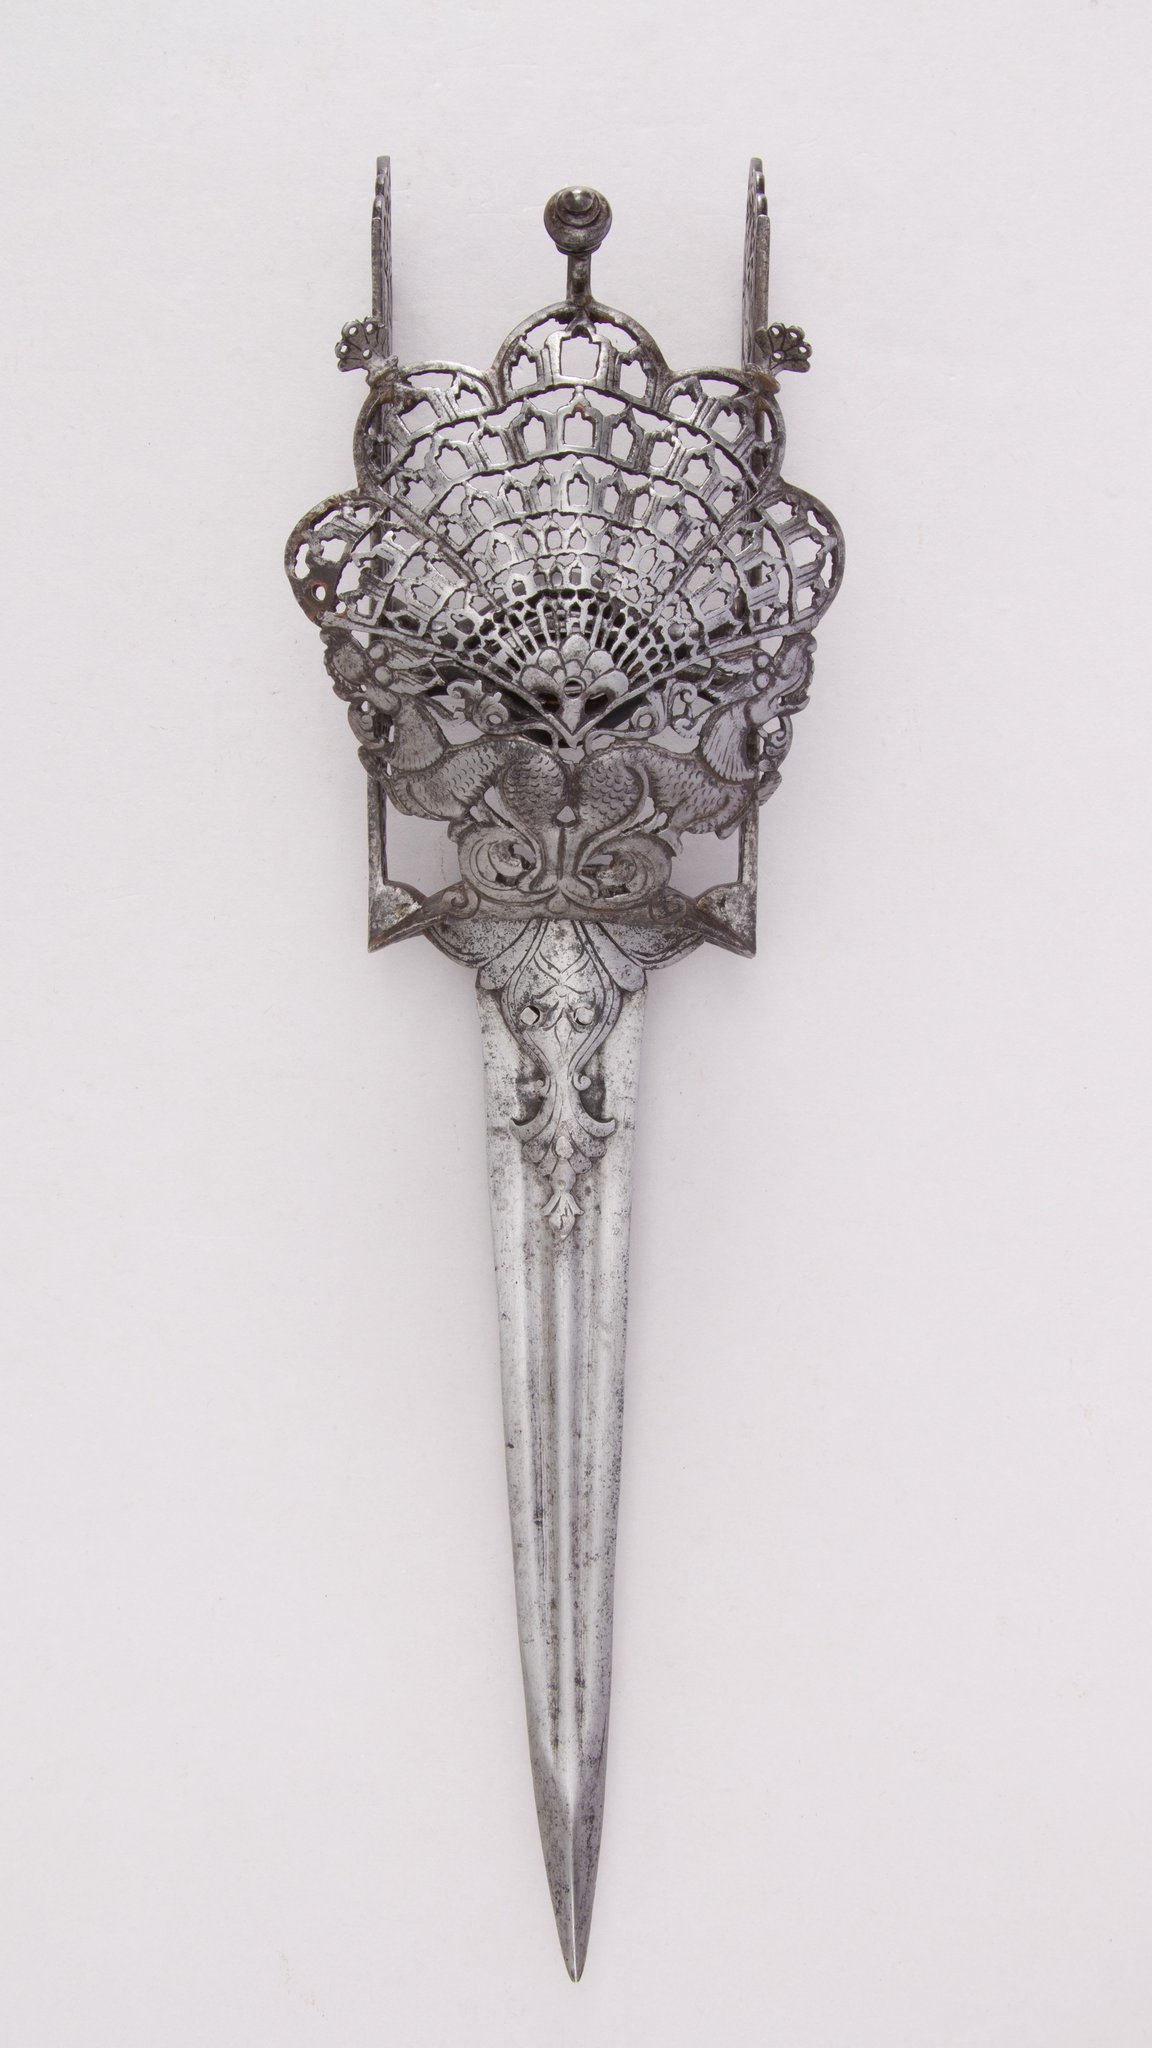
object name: dagger katar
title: Guarded Dagger (Katar)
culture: indian, thanjavur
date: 1601-1700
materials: steel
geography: india